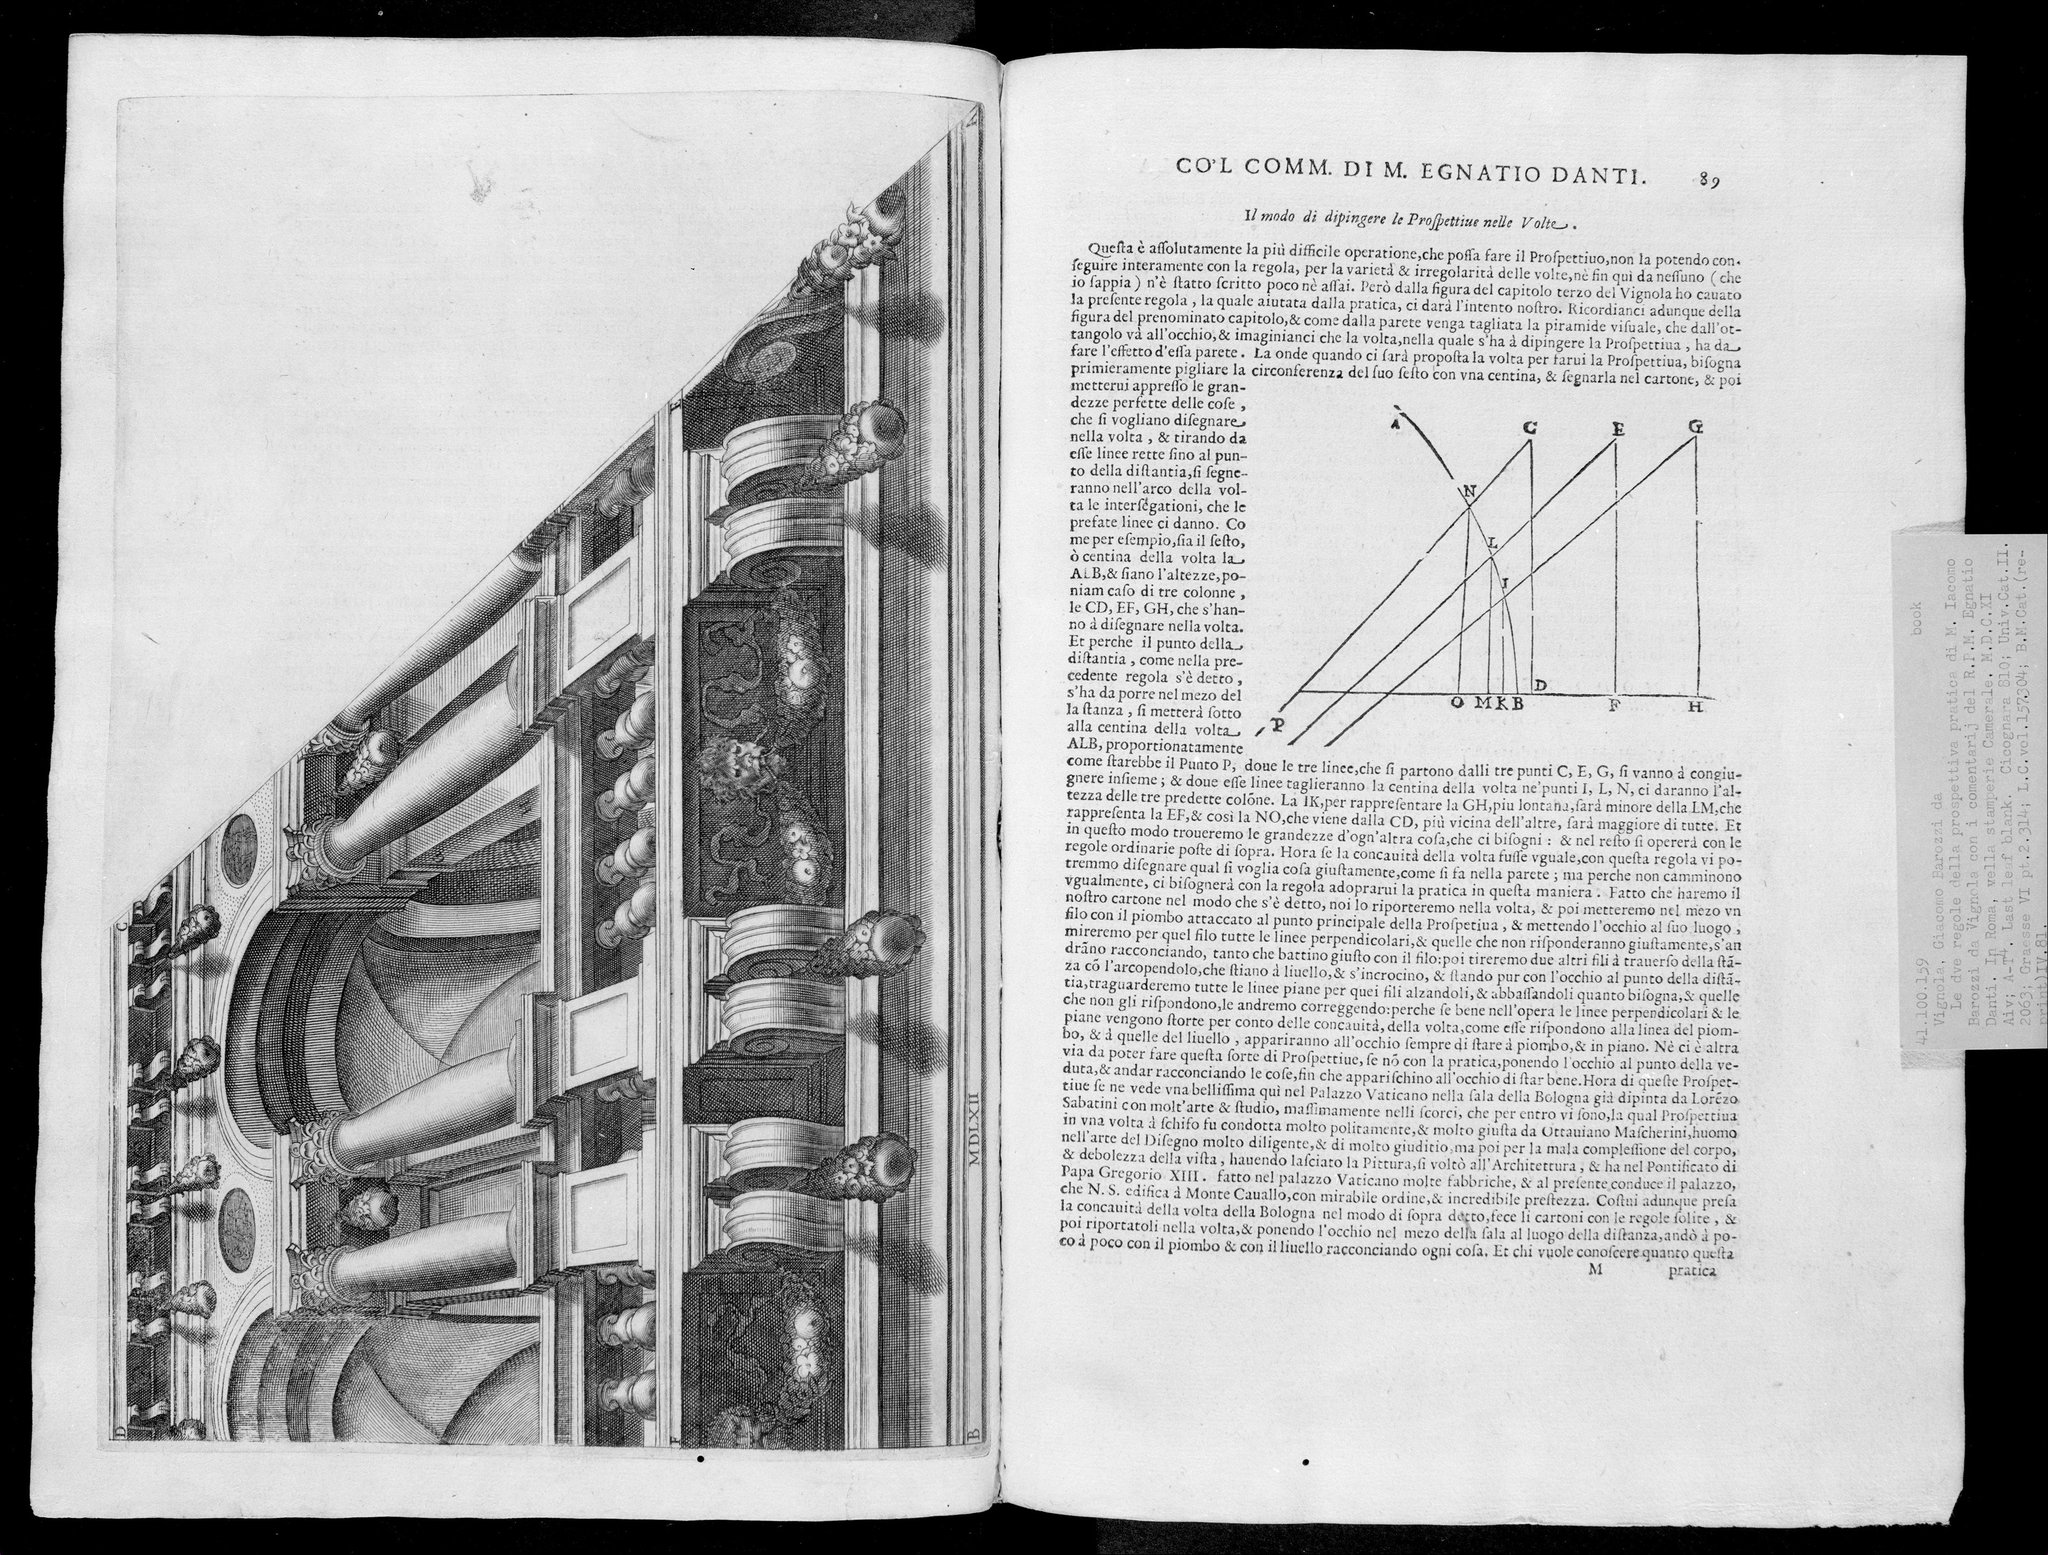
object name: book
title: Le due regole della prospettiva practica di M. Iacomo Barozzi da Vignola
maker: jacopo [giacomo] barozzi da vignola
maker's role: author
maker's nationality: italian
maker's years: 1507-1573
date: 1611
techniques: engraving, printing, woodcut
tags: architecture